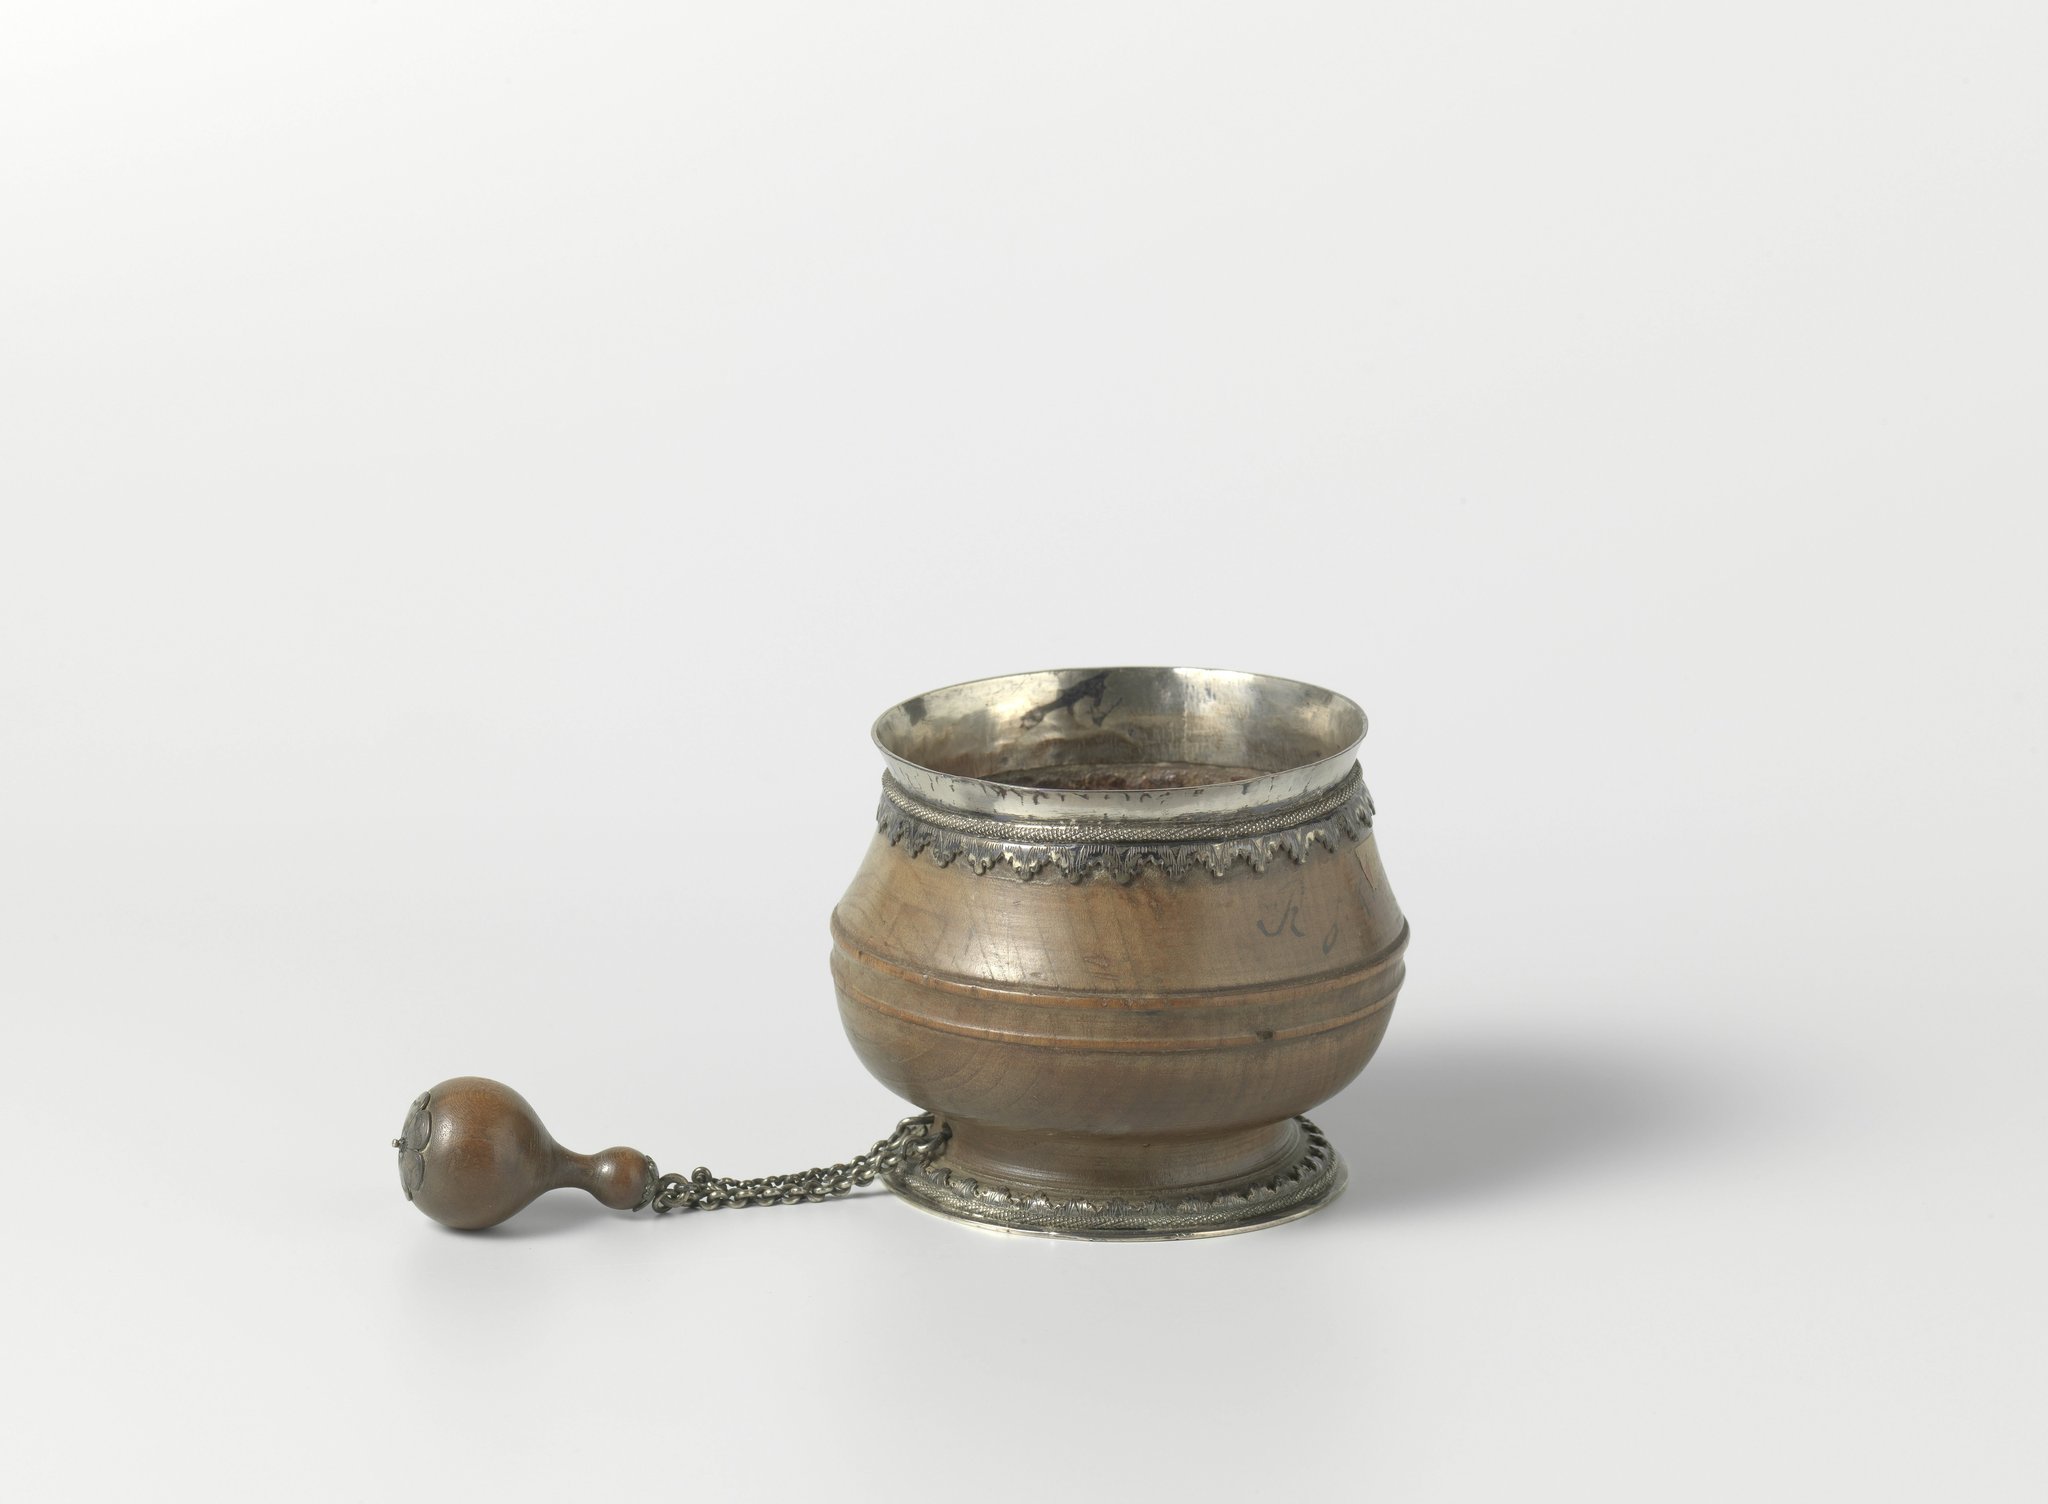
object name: bowl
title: Beggars’ Bowl with a Gourd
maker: Anonymous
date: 1566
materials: ink, paper, silver, wood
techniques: engraving, forging, turning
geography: low countries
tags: netherlands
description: When in 1566 nobles begged the governor, Margaret of Parma, to halt the persecution of the Protestants, someone reassured her with the words: ‘Fear not, my lady, they are nothing but beggars,’ called ‘gueux’ in French. The dissenting nobles immediately adopt the negatively meant geus as a badge of honour. Their symbols are the beggars’ bowl and pouch. Some of these bowls are fairly luxurious and were reserved for that reason.